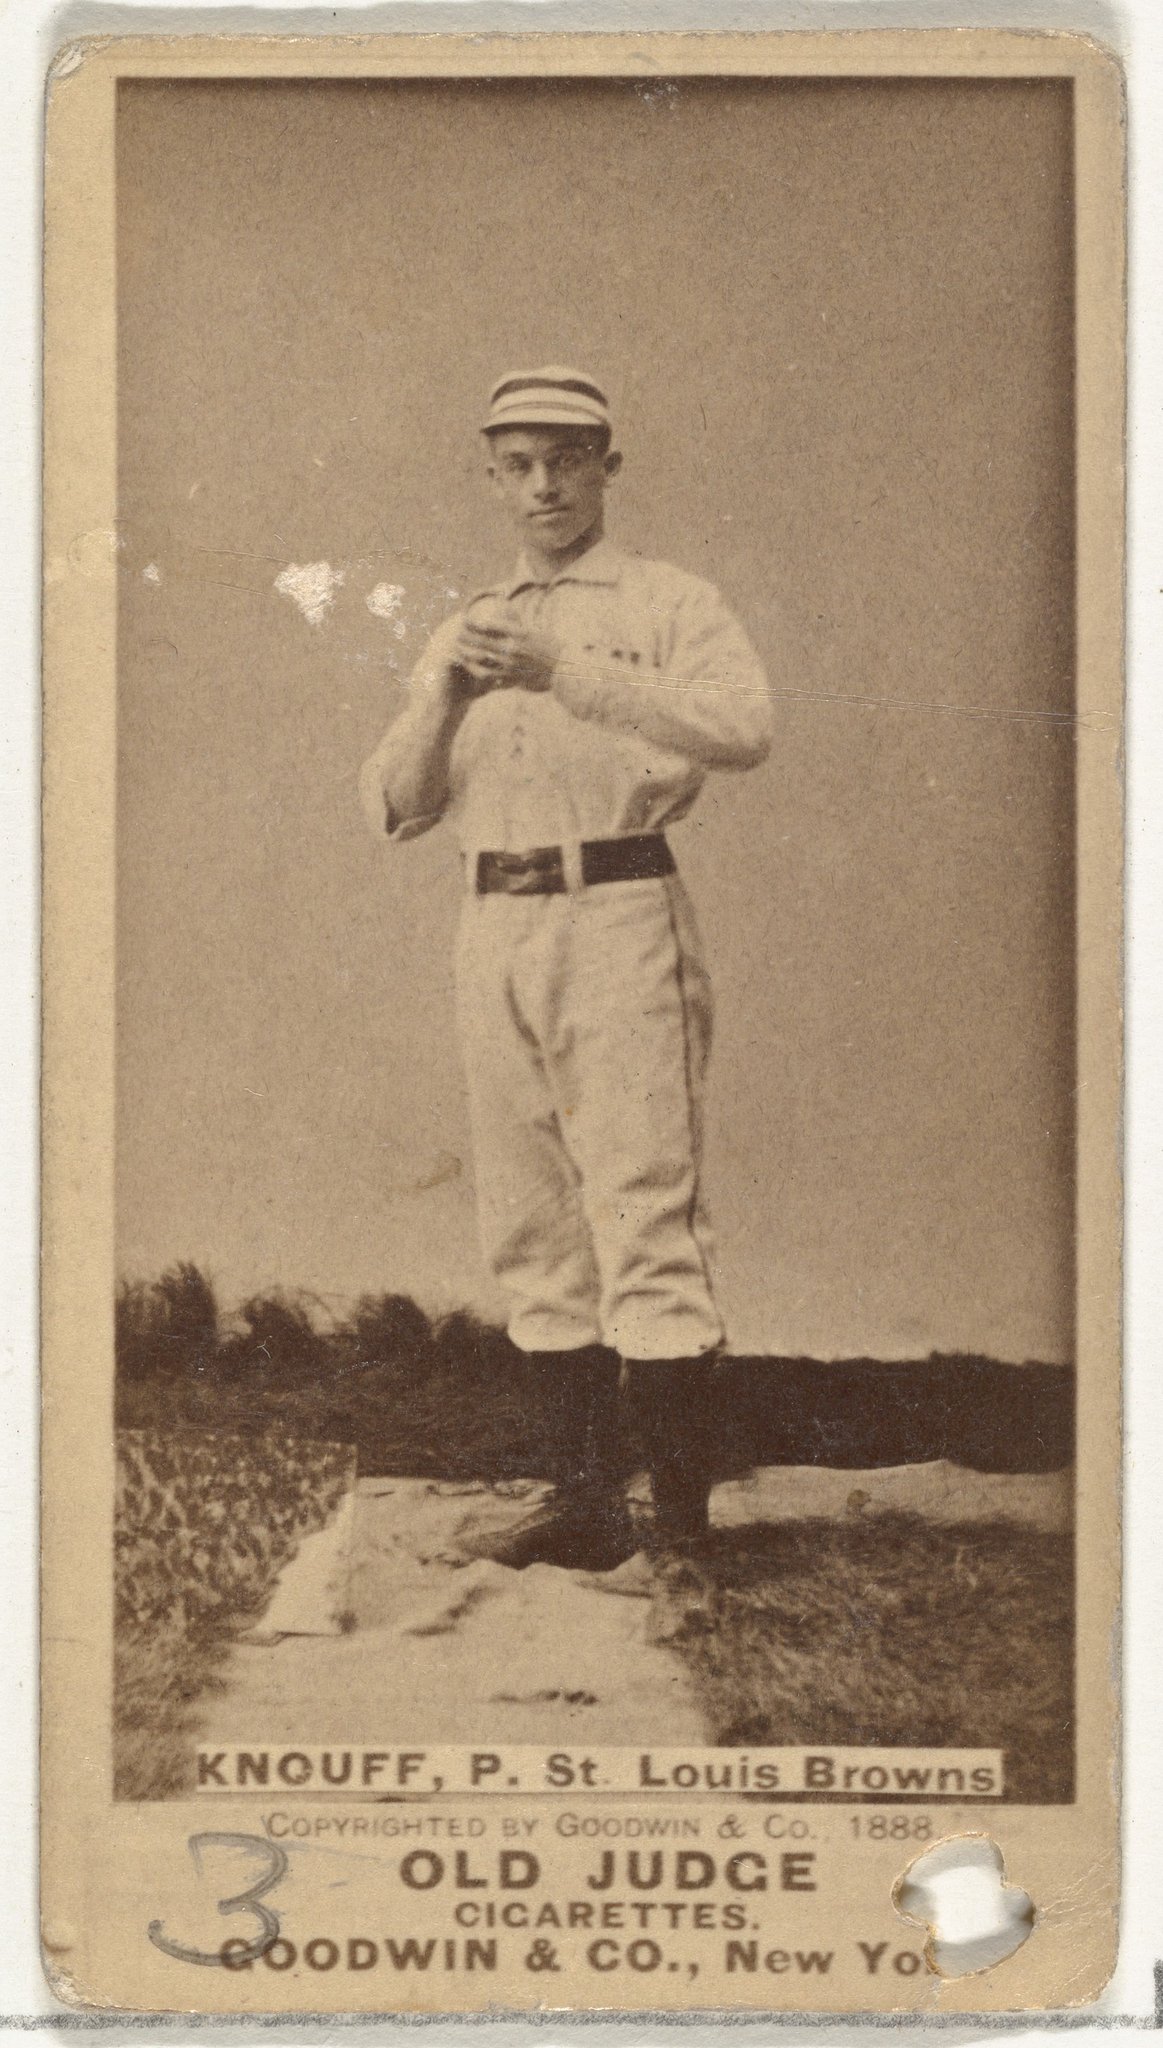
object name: baseball card, photograph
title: Edward Augustine "Ed" Knouff, Pitcher, St. Louis Browns, from the Old Judge series (N172) for Old Judge Cigarettes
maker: goodwin & company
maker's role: publisher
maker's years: 1850-1950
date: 1888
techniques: albumen silver print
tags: men,portraits,baseball,athletes